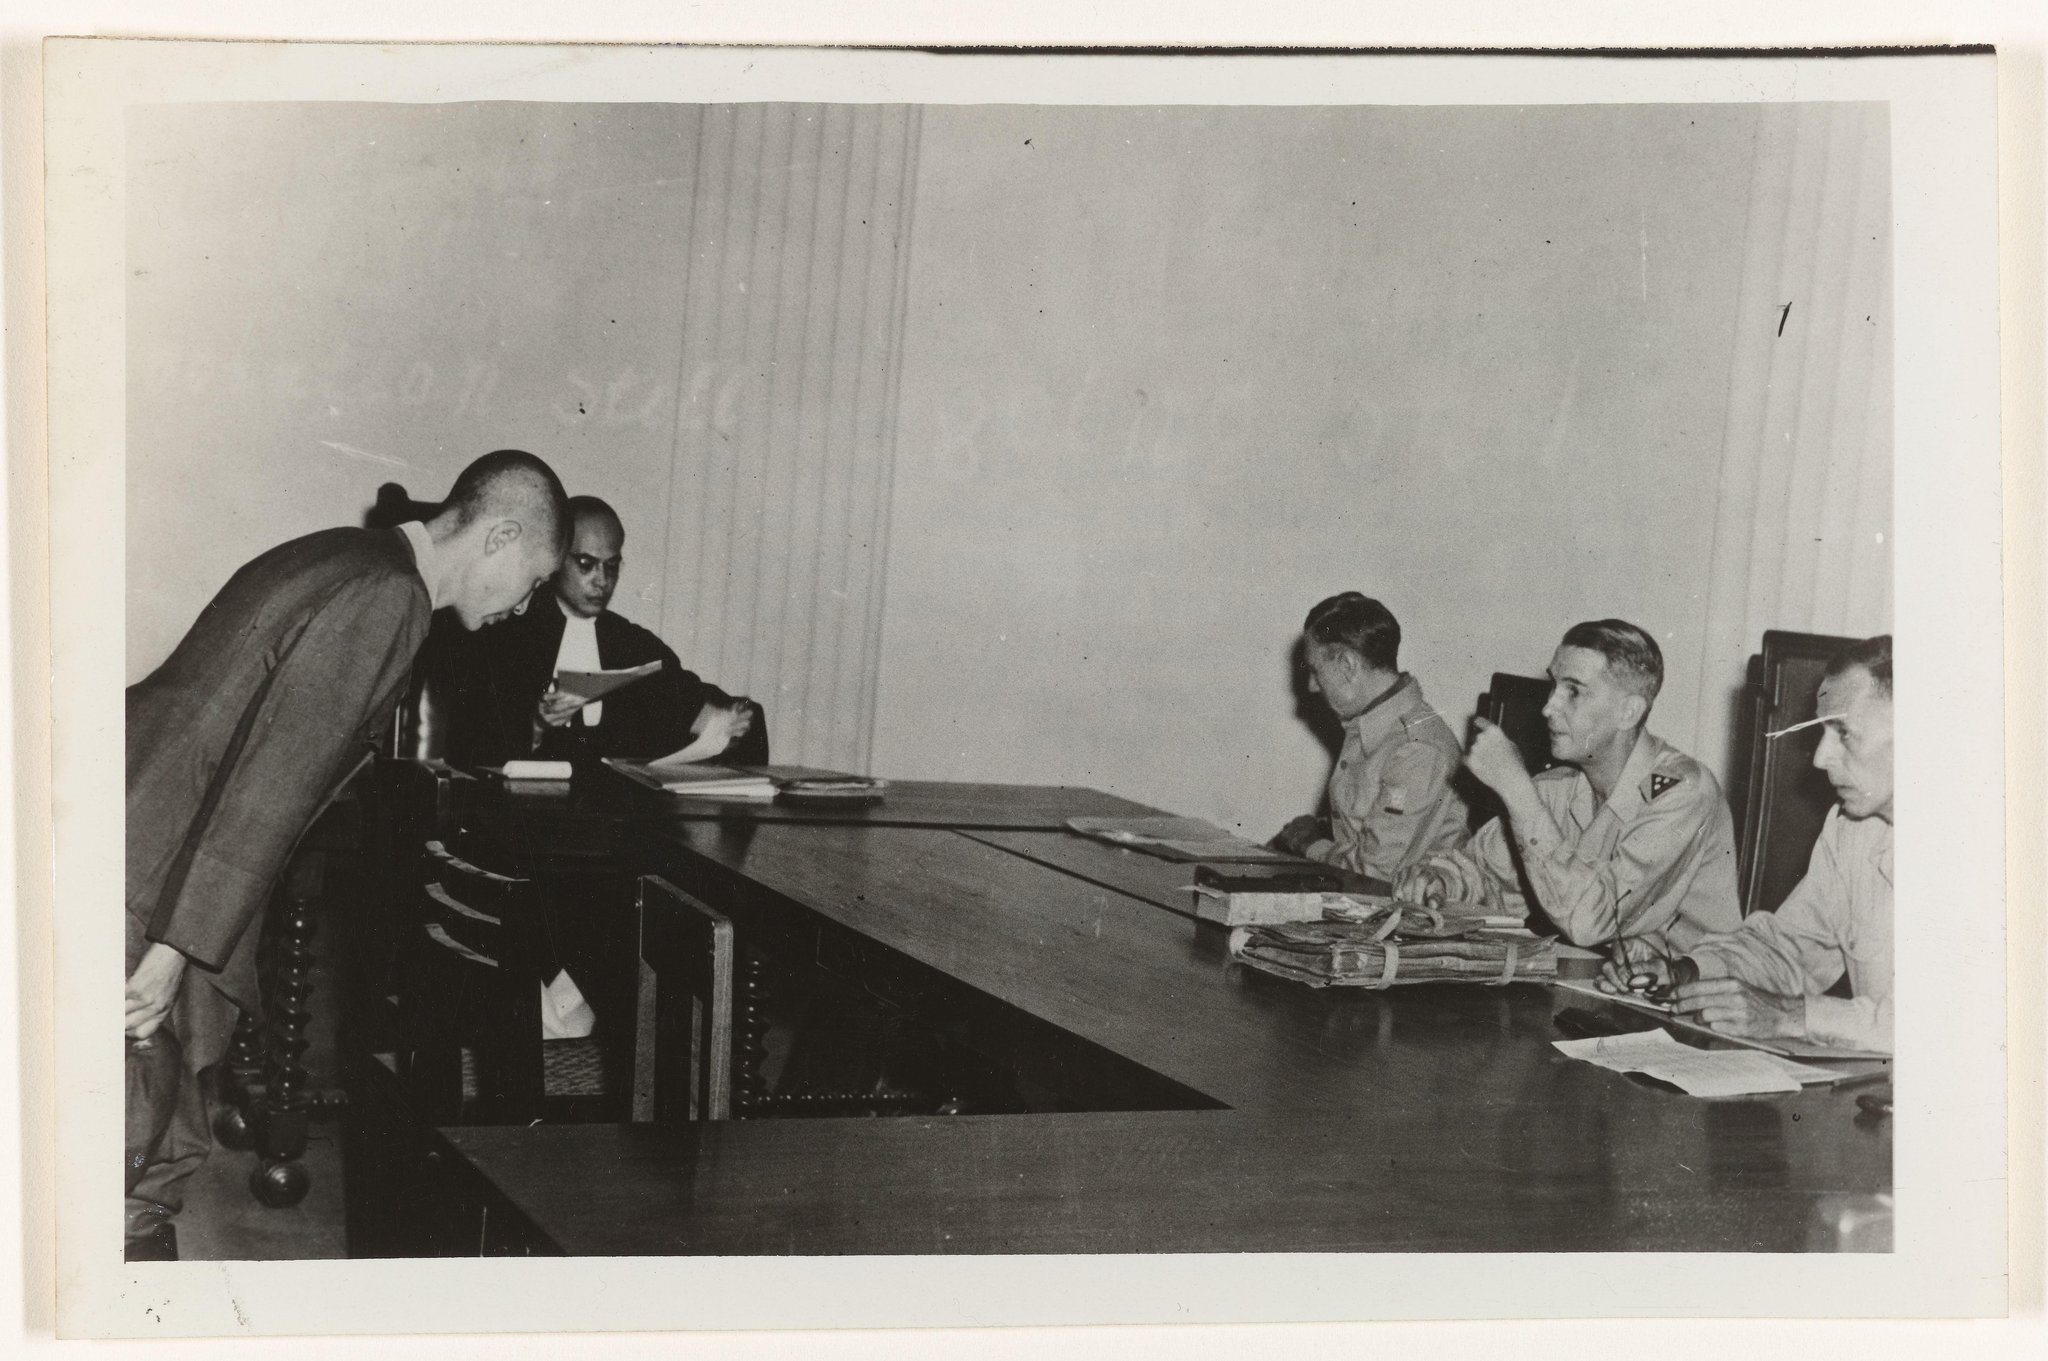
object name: photograph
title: Japanse oorlogsmisdadiger Sonei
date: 1946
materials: photographic support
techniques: photography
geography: dutch east indies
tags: dutch east indies, the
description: De Japanse oorlogsmisdadiger Sonei, de beul van het vrouwenkamp Tjideng, staat in Nederlands-Indië voor de rechtbank.